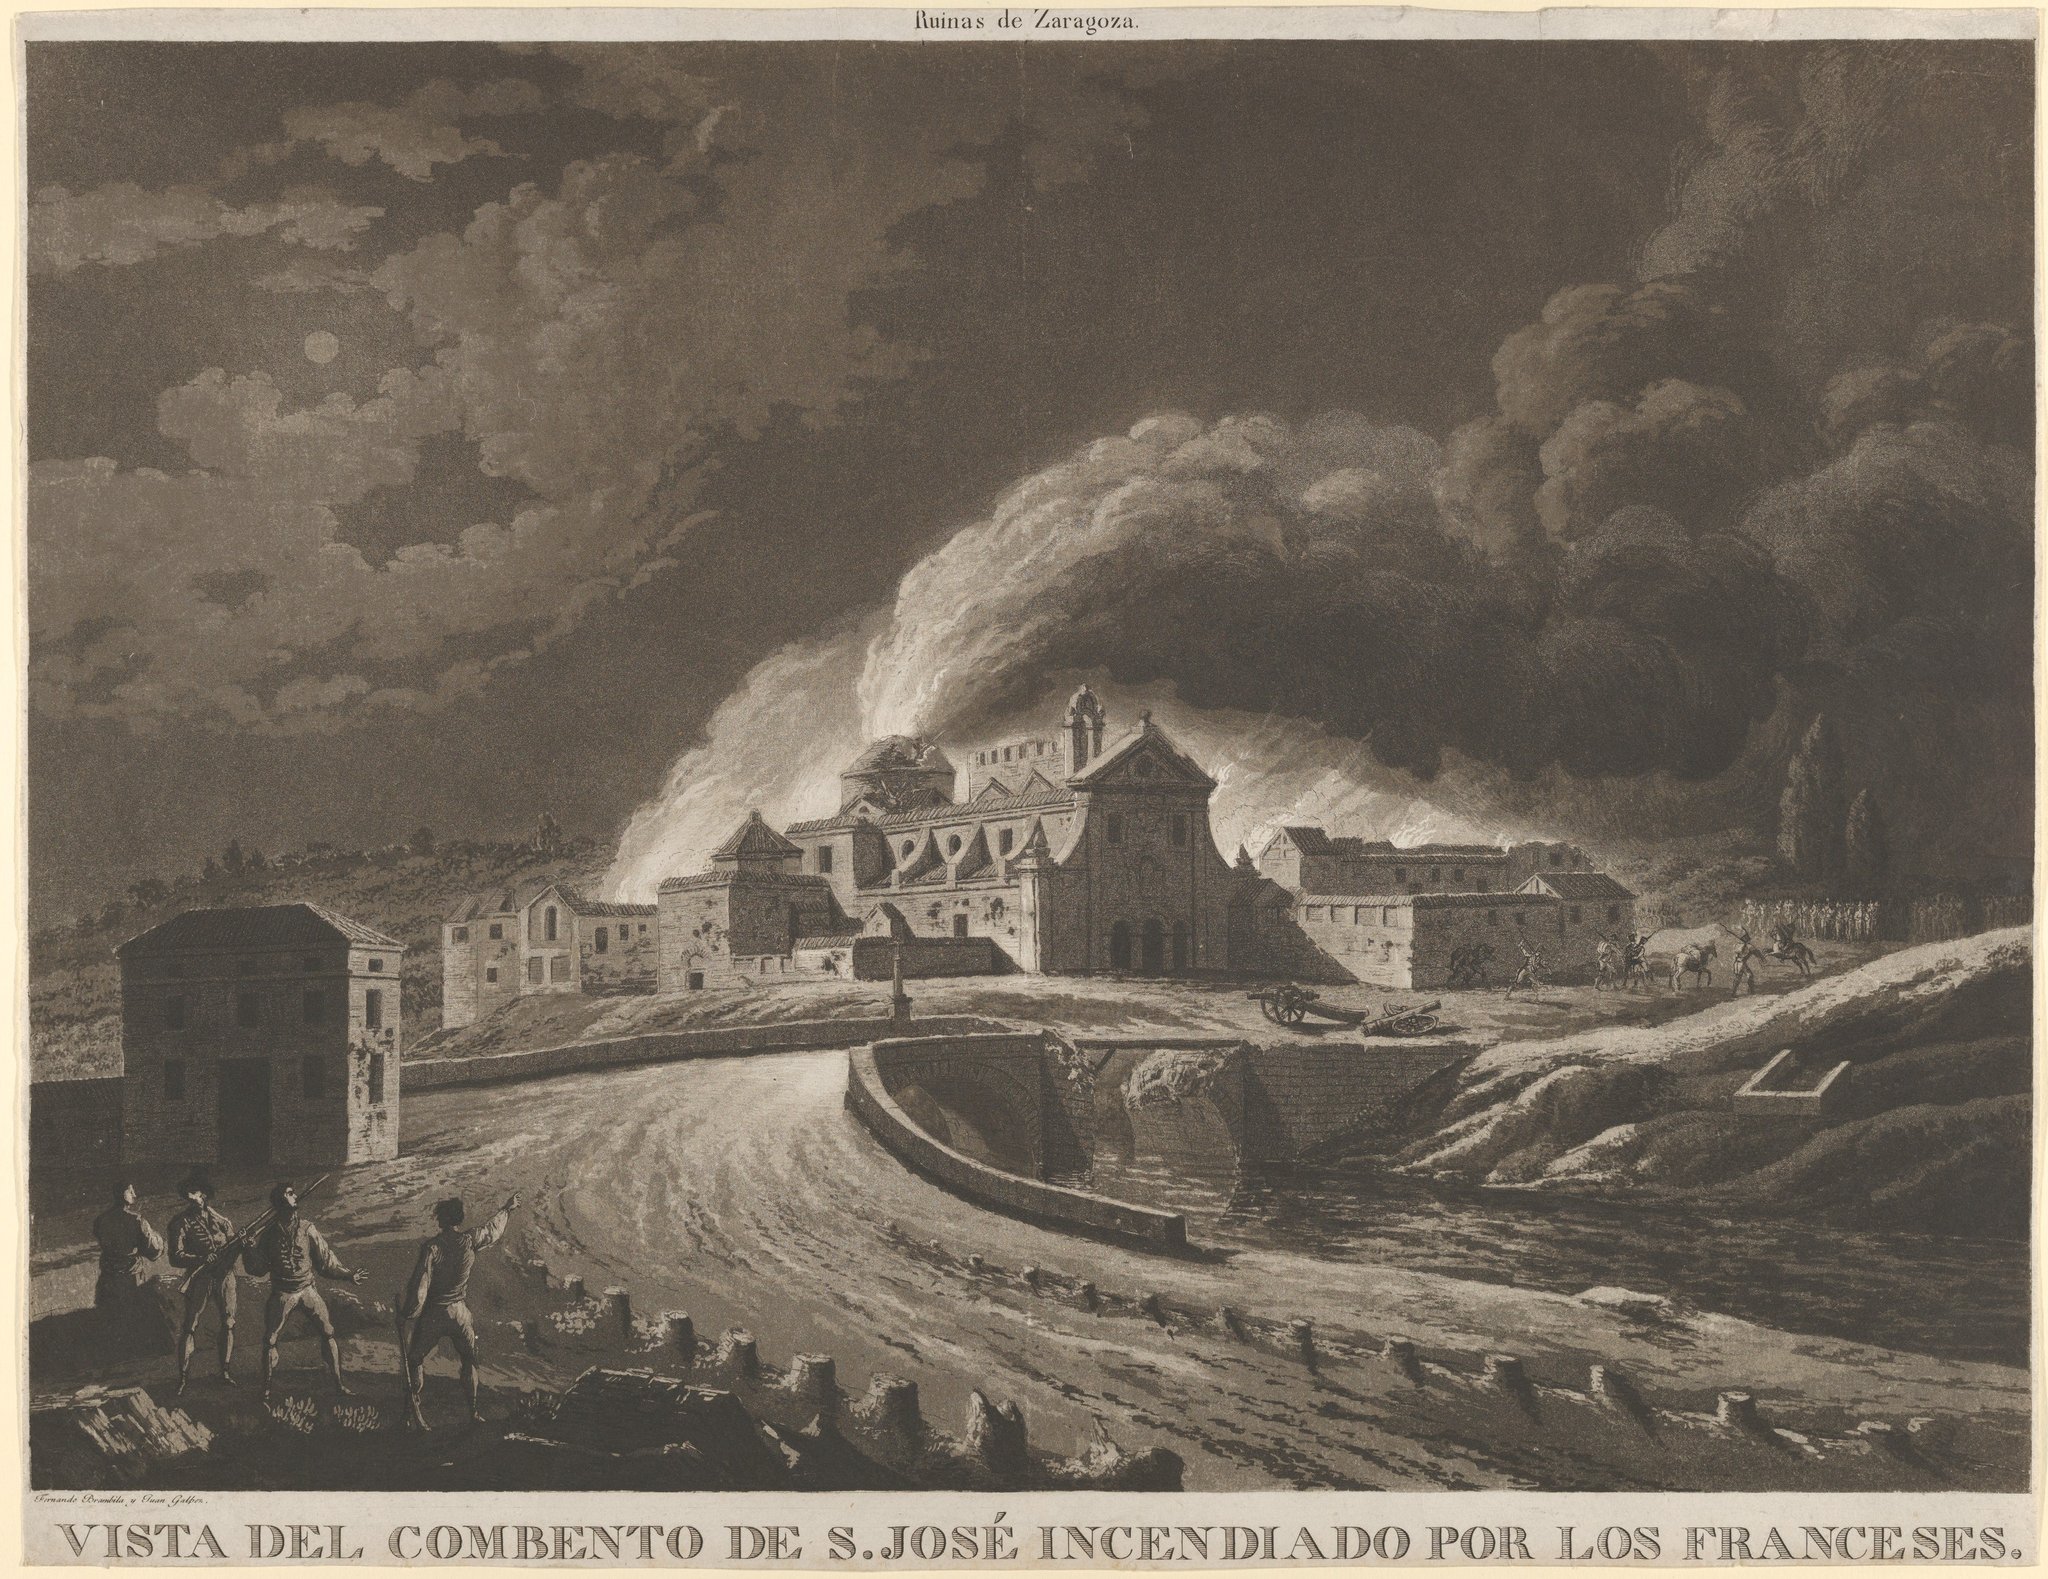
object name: print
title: View of the Convent of San José in Saragossa set alight after bombing by the invading French army during the Napoleonic war in Spain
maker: fernando brambila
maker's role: artist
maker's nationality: spanish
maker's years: 1763-1834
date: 1808-1814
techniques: aquatint, etching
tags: buildings,wars,men